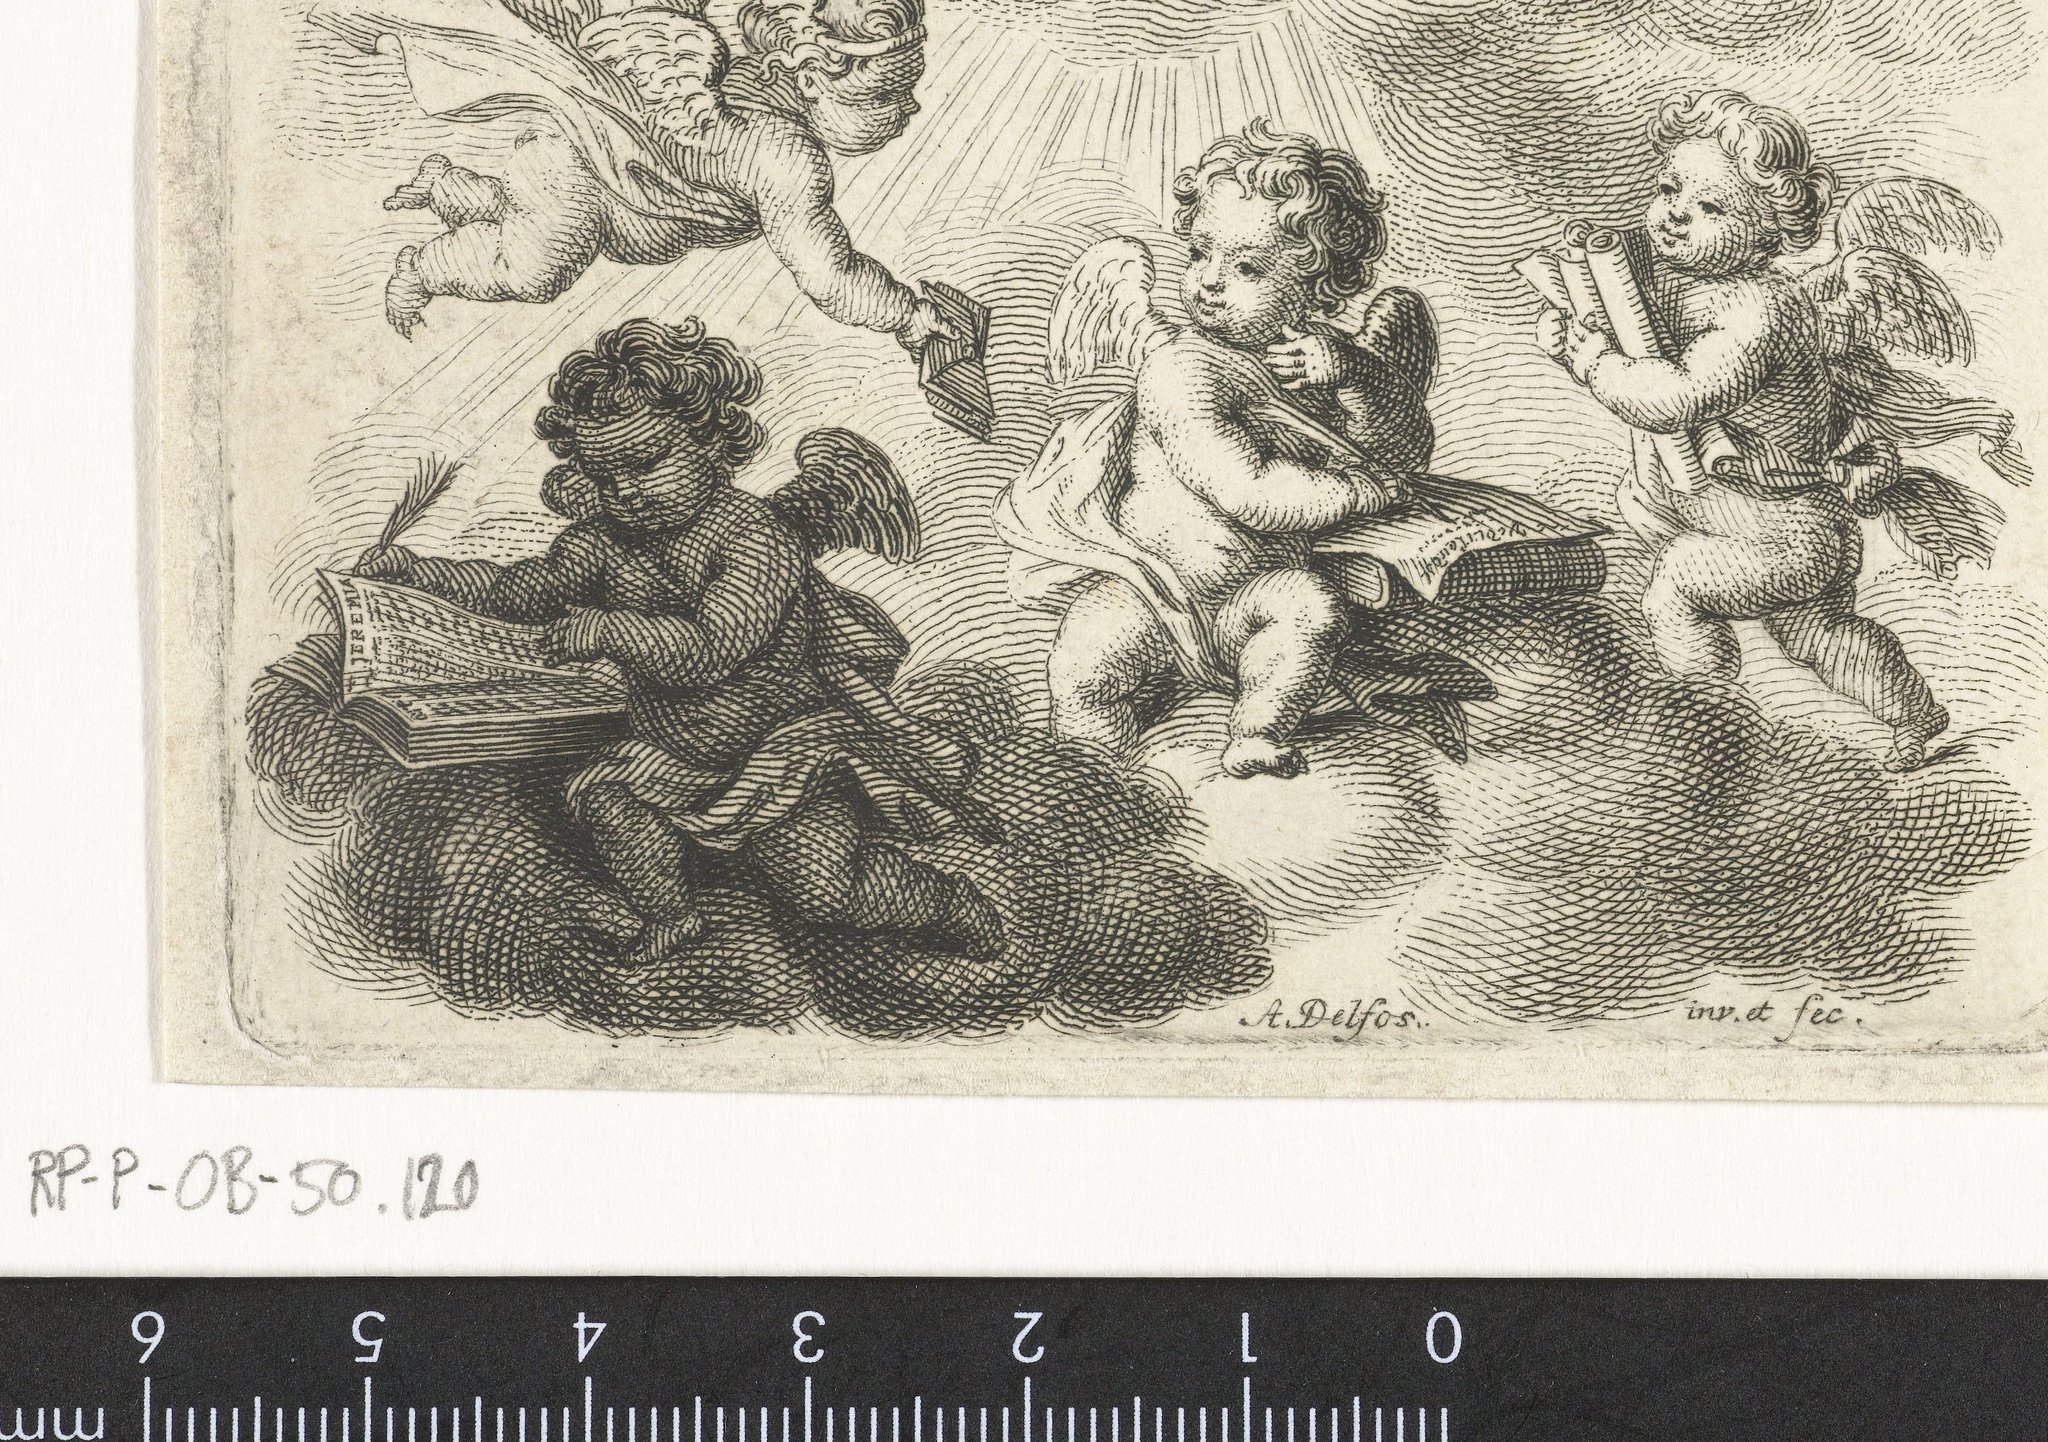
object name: print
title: Allegorie op kunsten en wetenschappen met vier putti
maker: abraham delfos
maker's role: draughtsman, painter, print maker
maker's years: 1731-1820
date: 1741-1820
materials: paper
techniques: etching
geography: leiden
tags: (story of) mercury (hermes), cupids: 'amores', 'amoretti', 'putti'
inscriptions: collector's mark: Lugt 2228